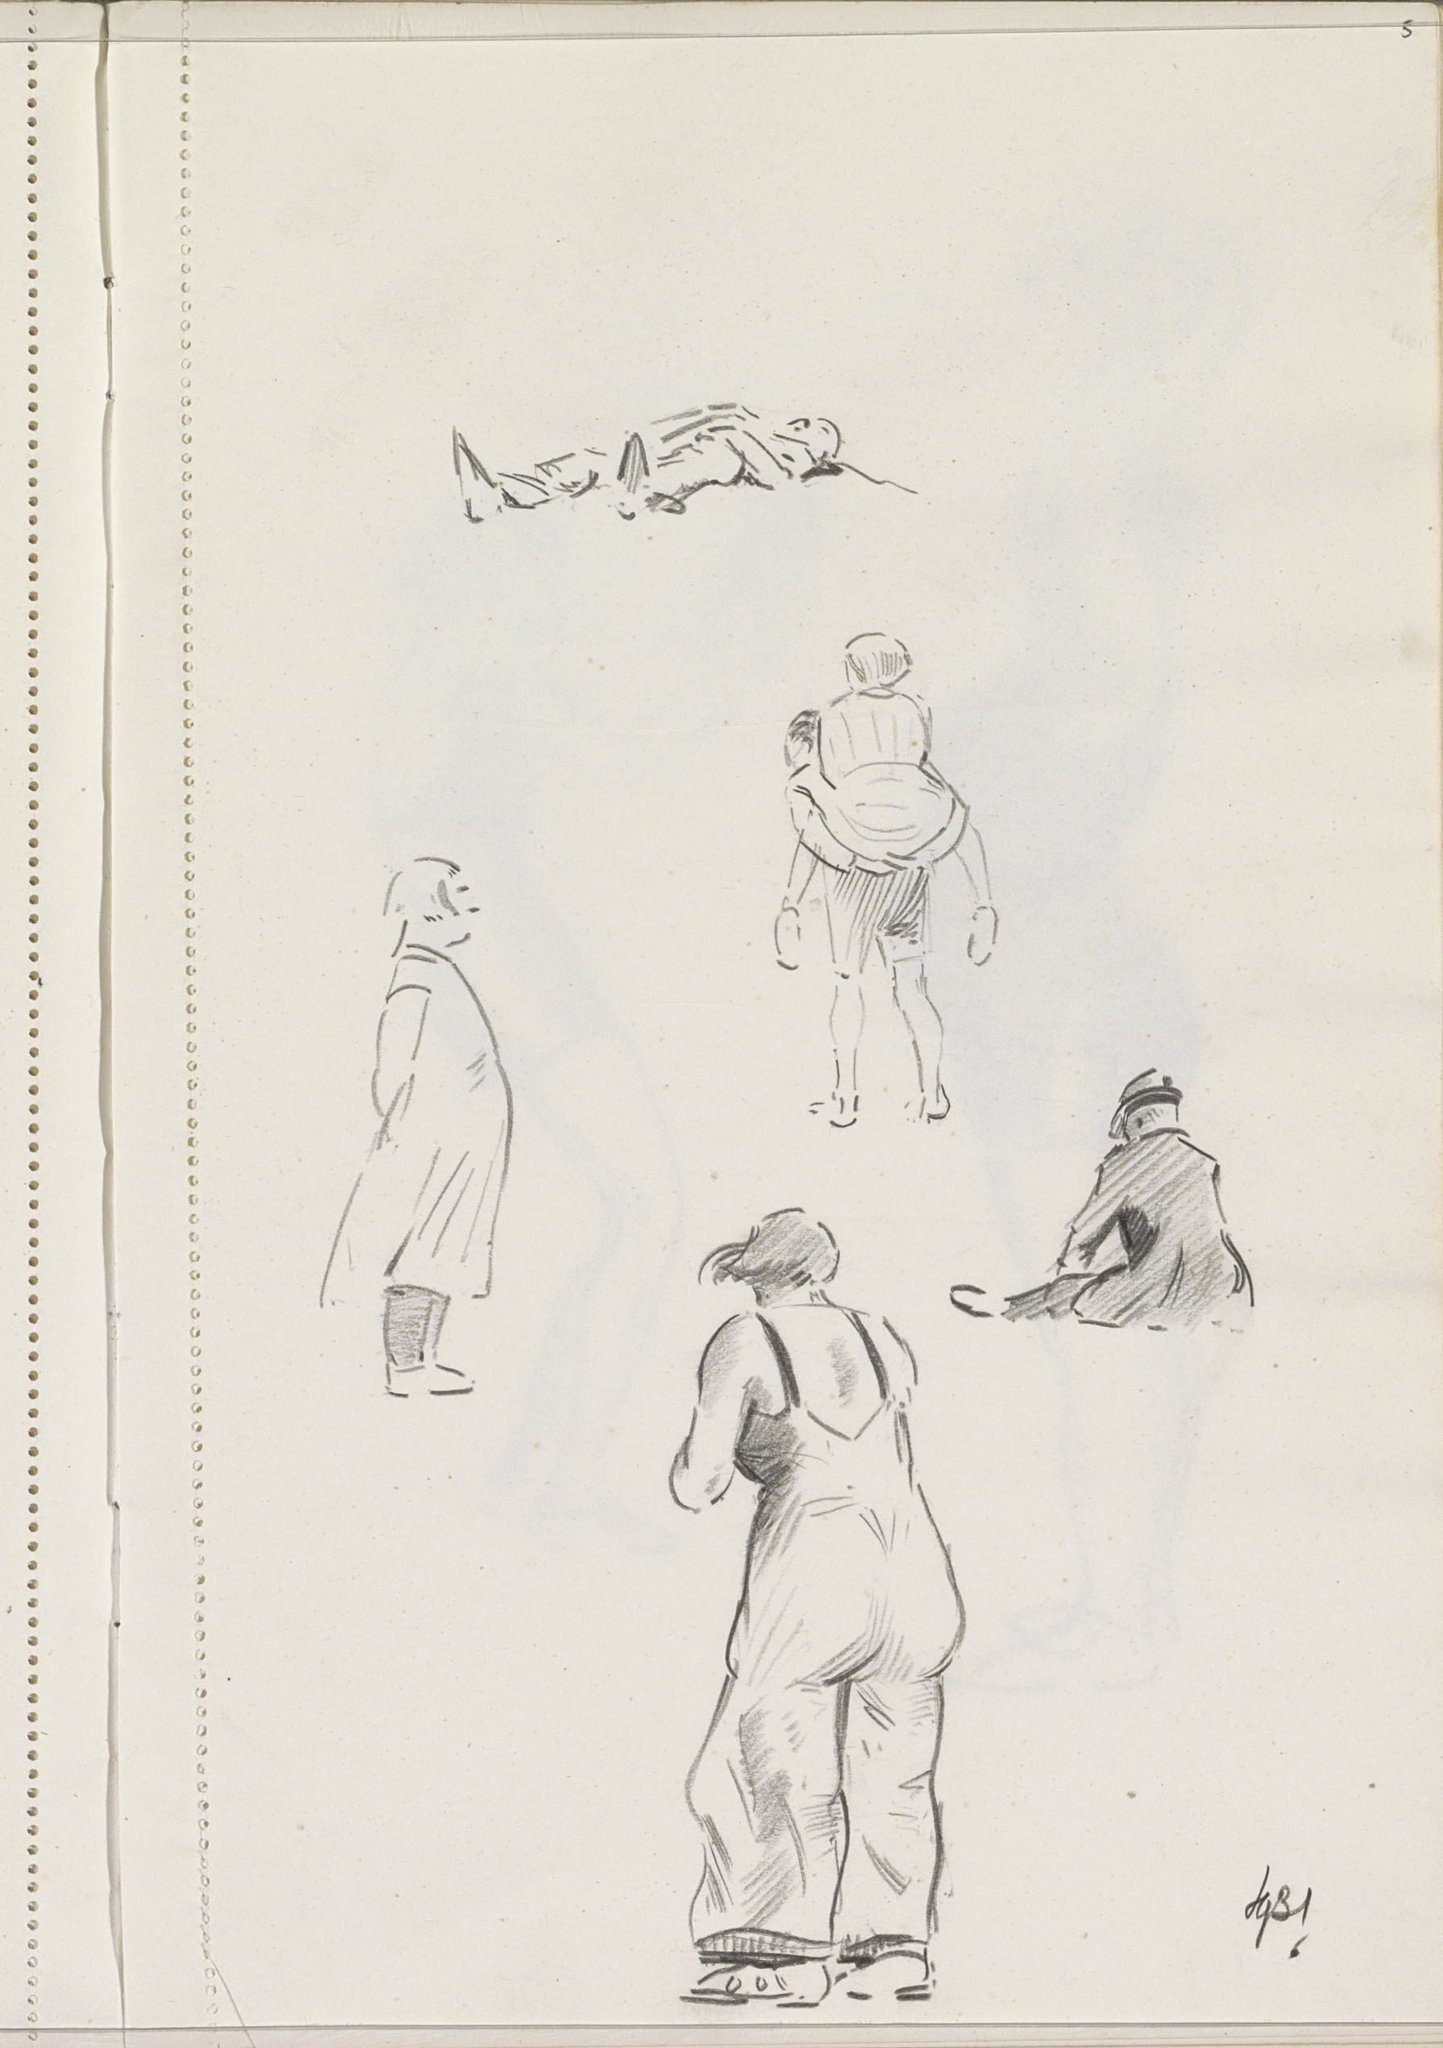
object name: sketchbook leaf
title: Liggende, staande, lopende en zittende figuren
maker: otto verhagen (i)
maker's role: draughtsman, print maker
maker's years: 1885-1951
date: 1931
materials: chalk, paper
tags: postures of the human figure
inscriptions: date: ‘1931’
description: Pagina 5 uit een schetsboek met 60 bladen.